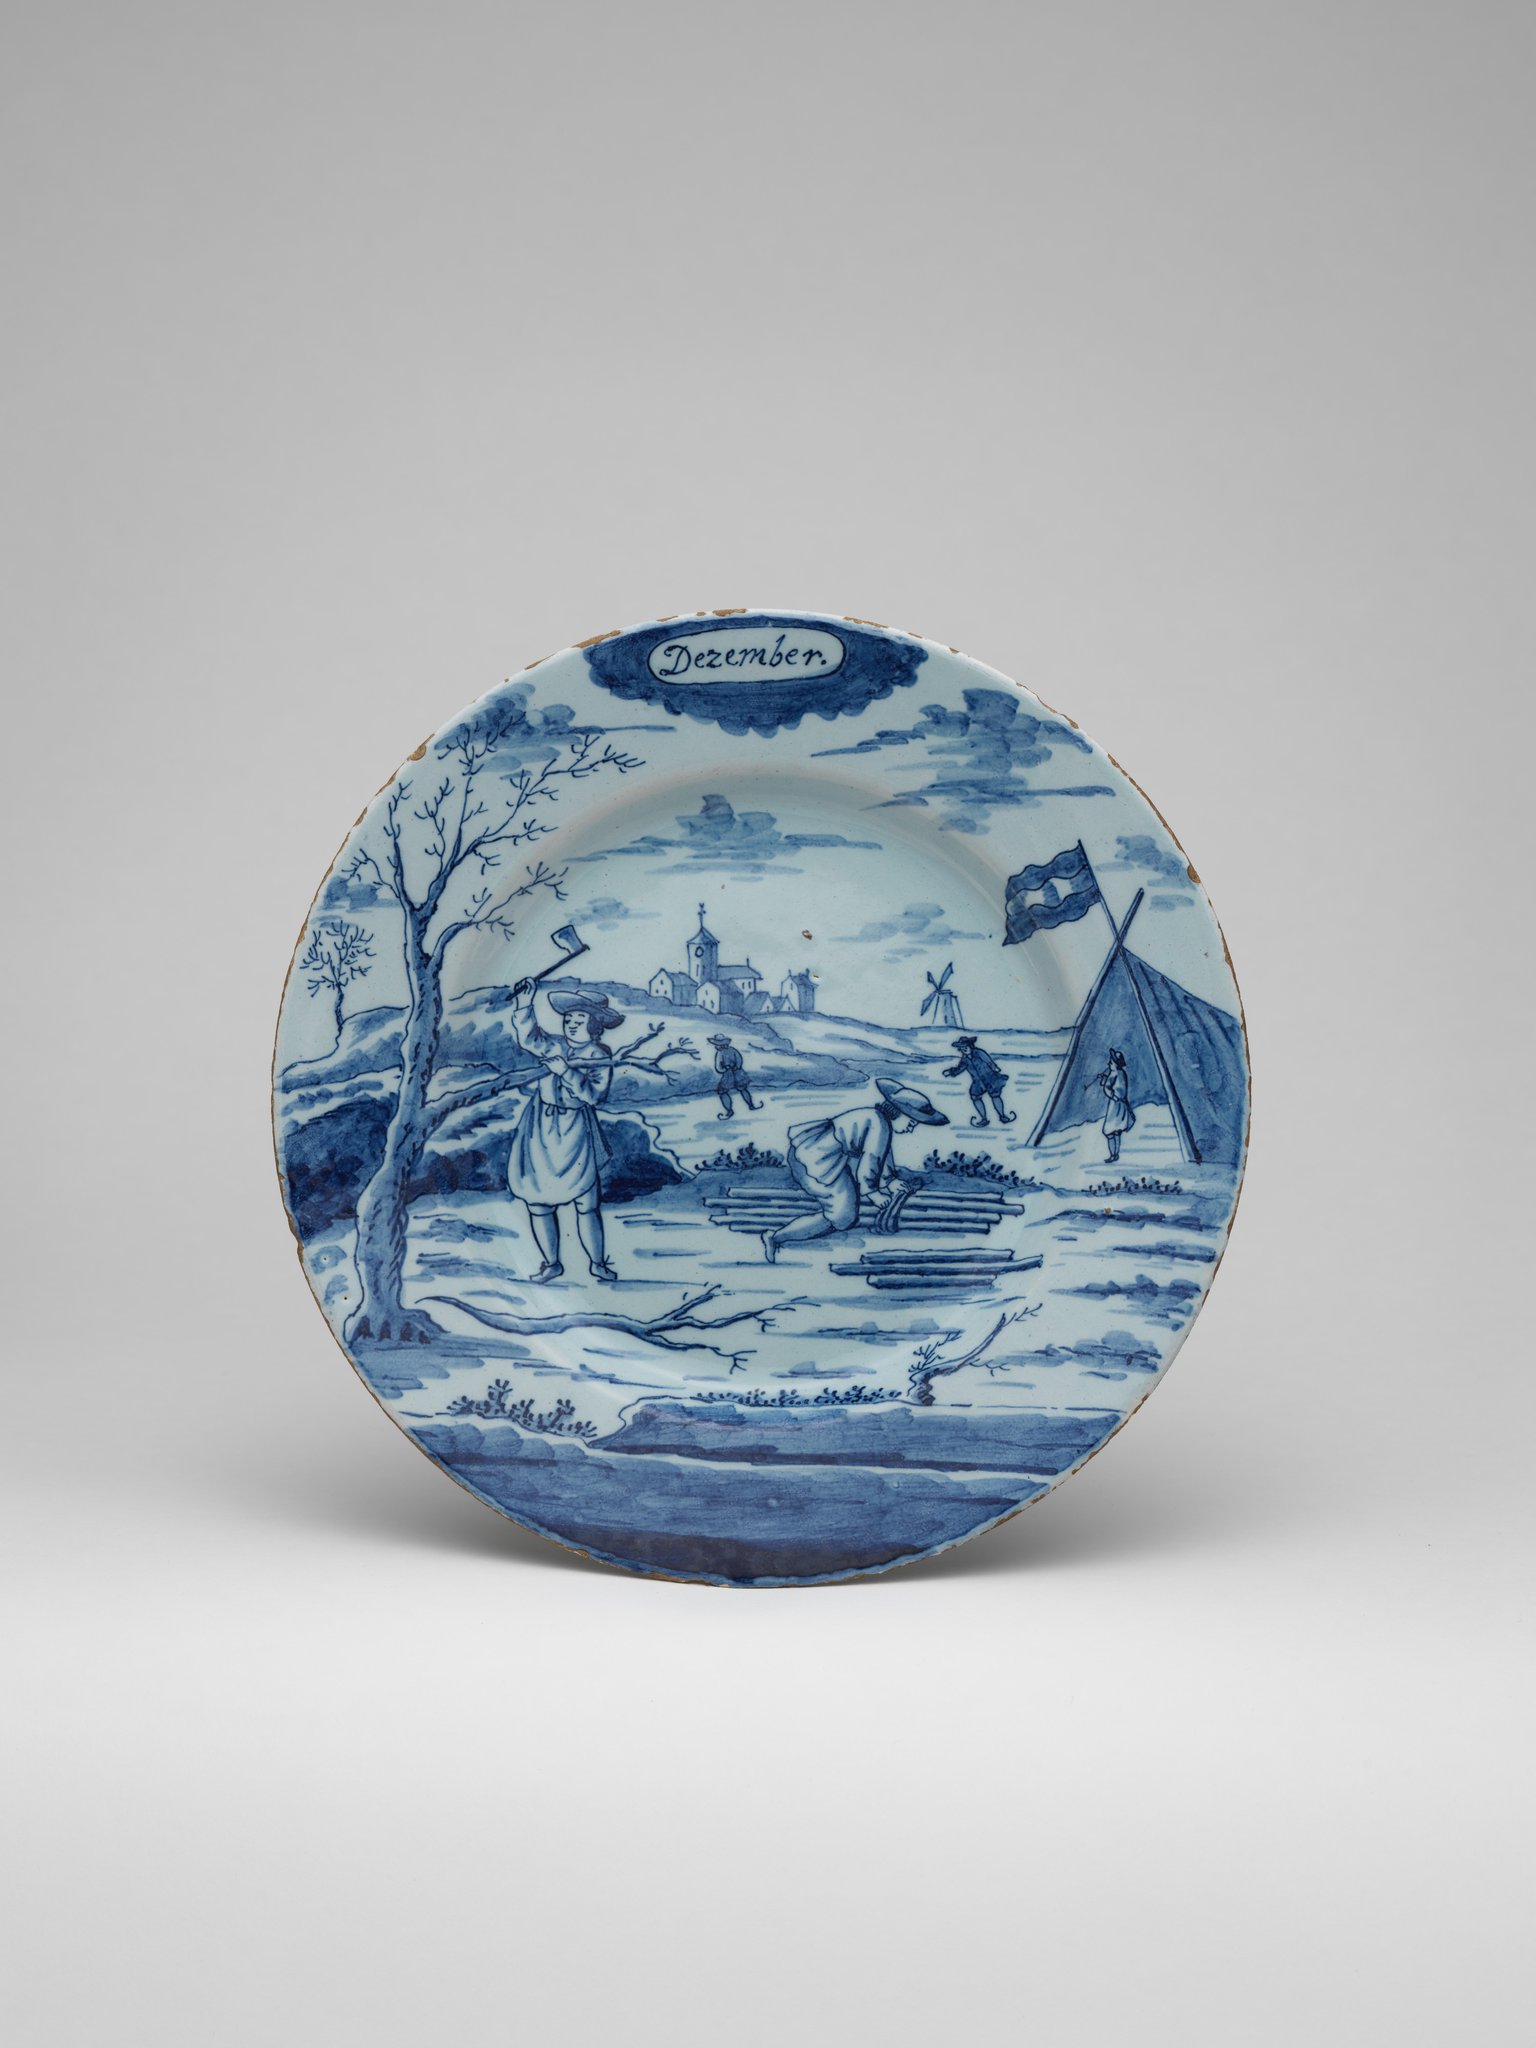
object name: plate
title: Plate (part of a set)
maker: de porceleyne bijl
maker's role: maker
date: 1764-1788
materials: earthenware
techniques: glazing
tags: buildings,landscapes,working,flags